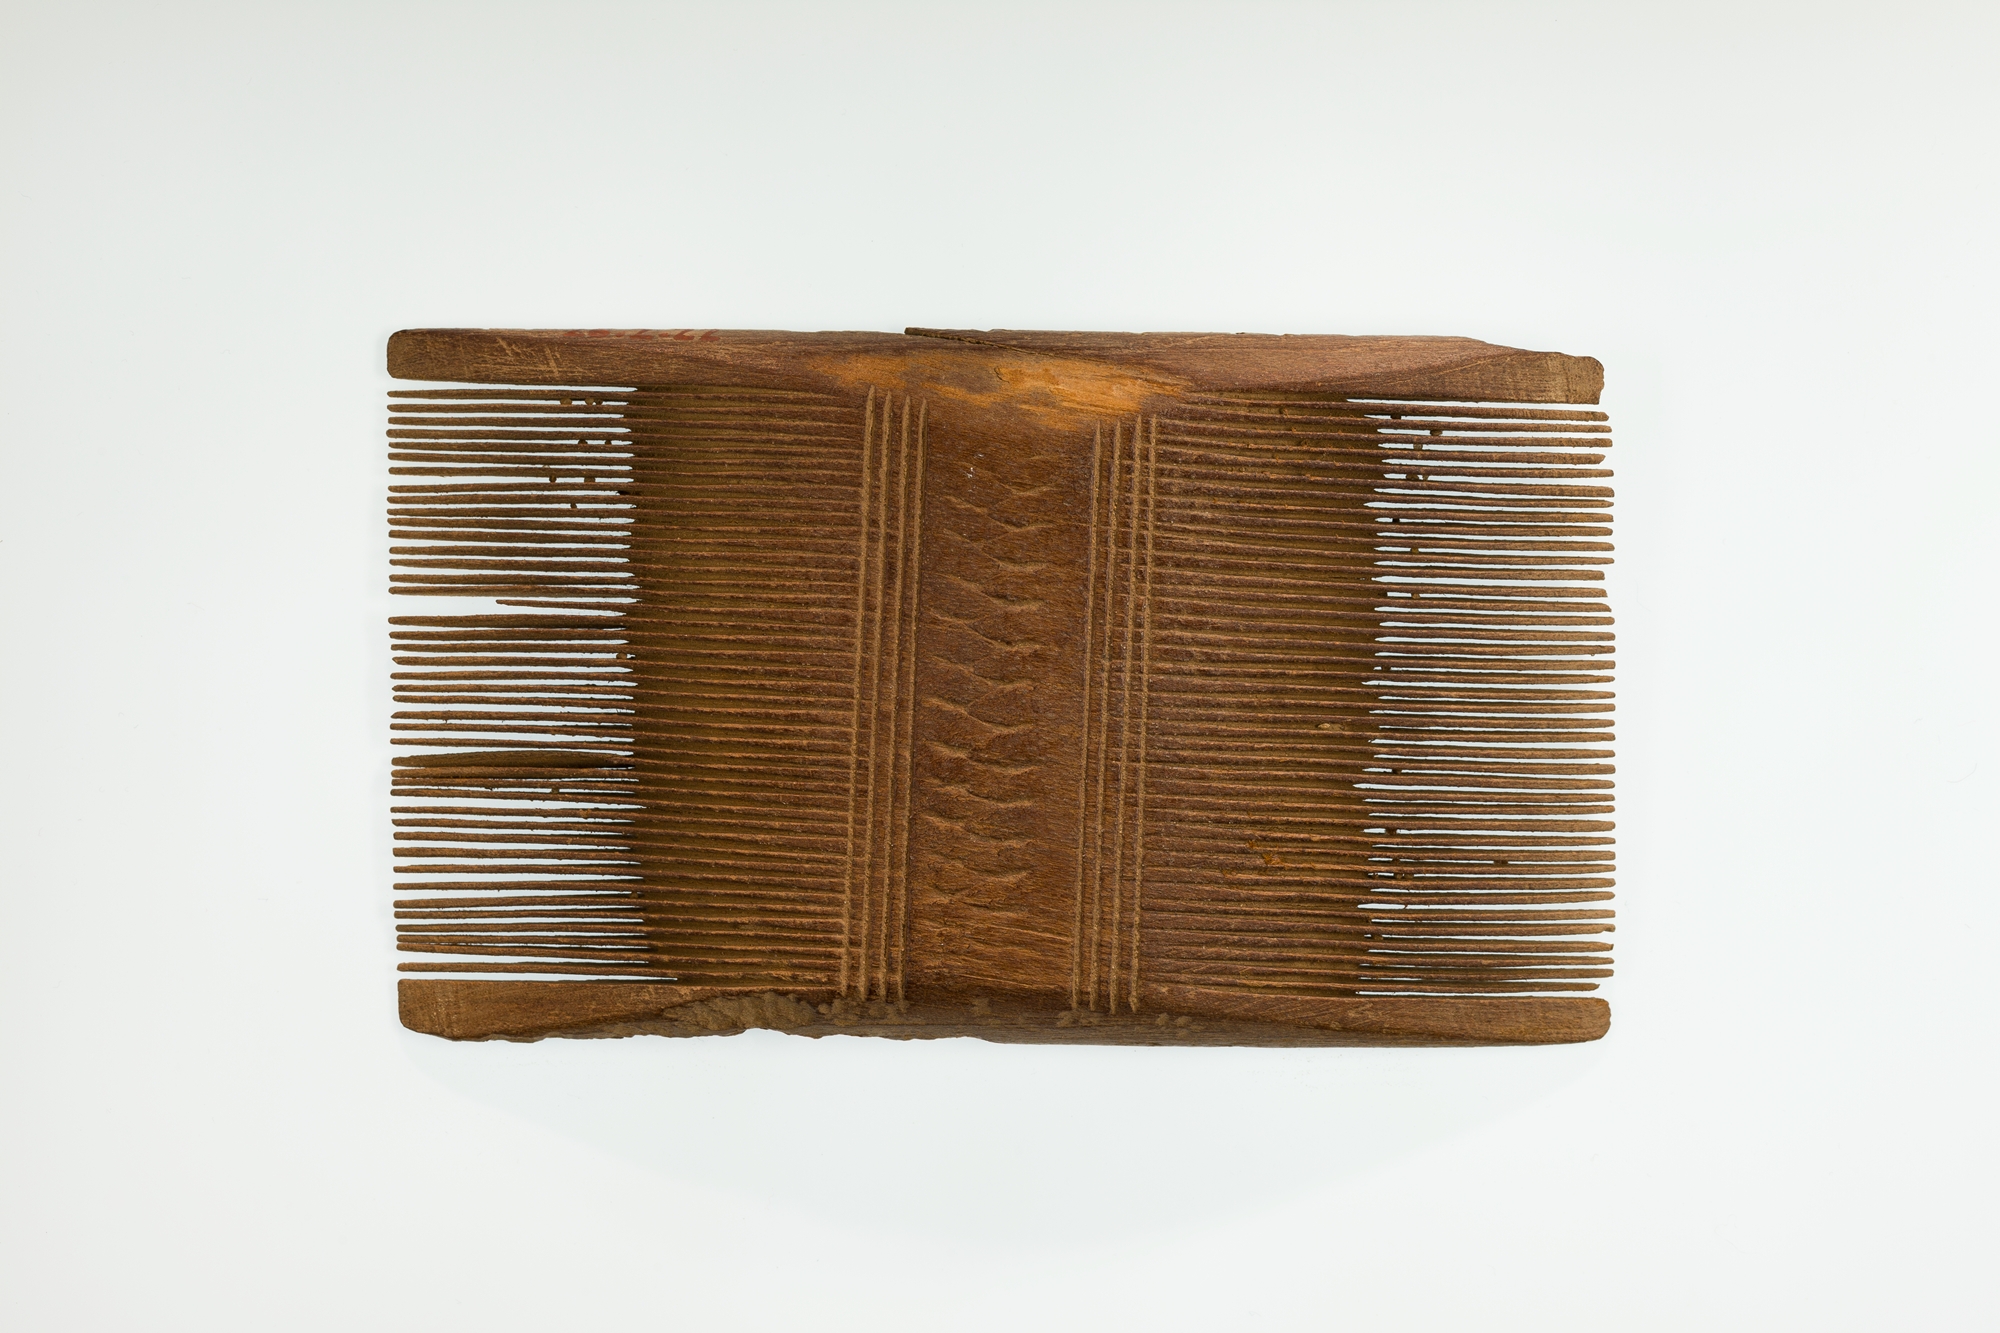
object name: comb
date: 1550-1295 BCE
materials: wood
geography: egypt